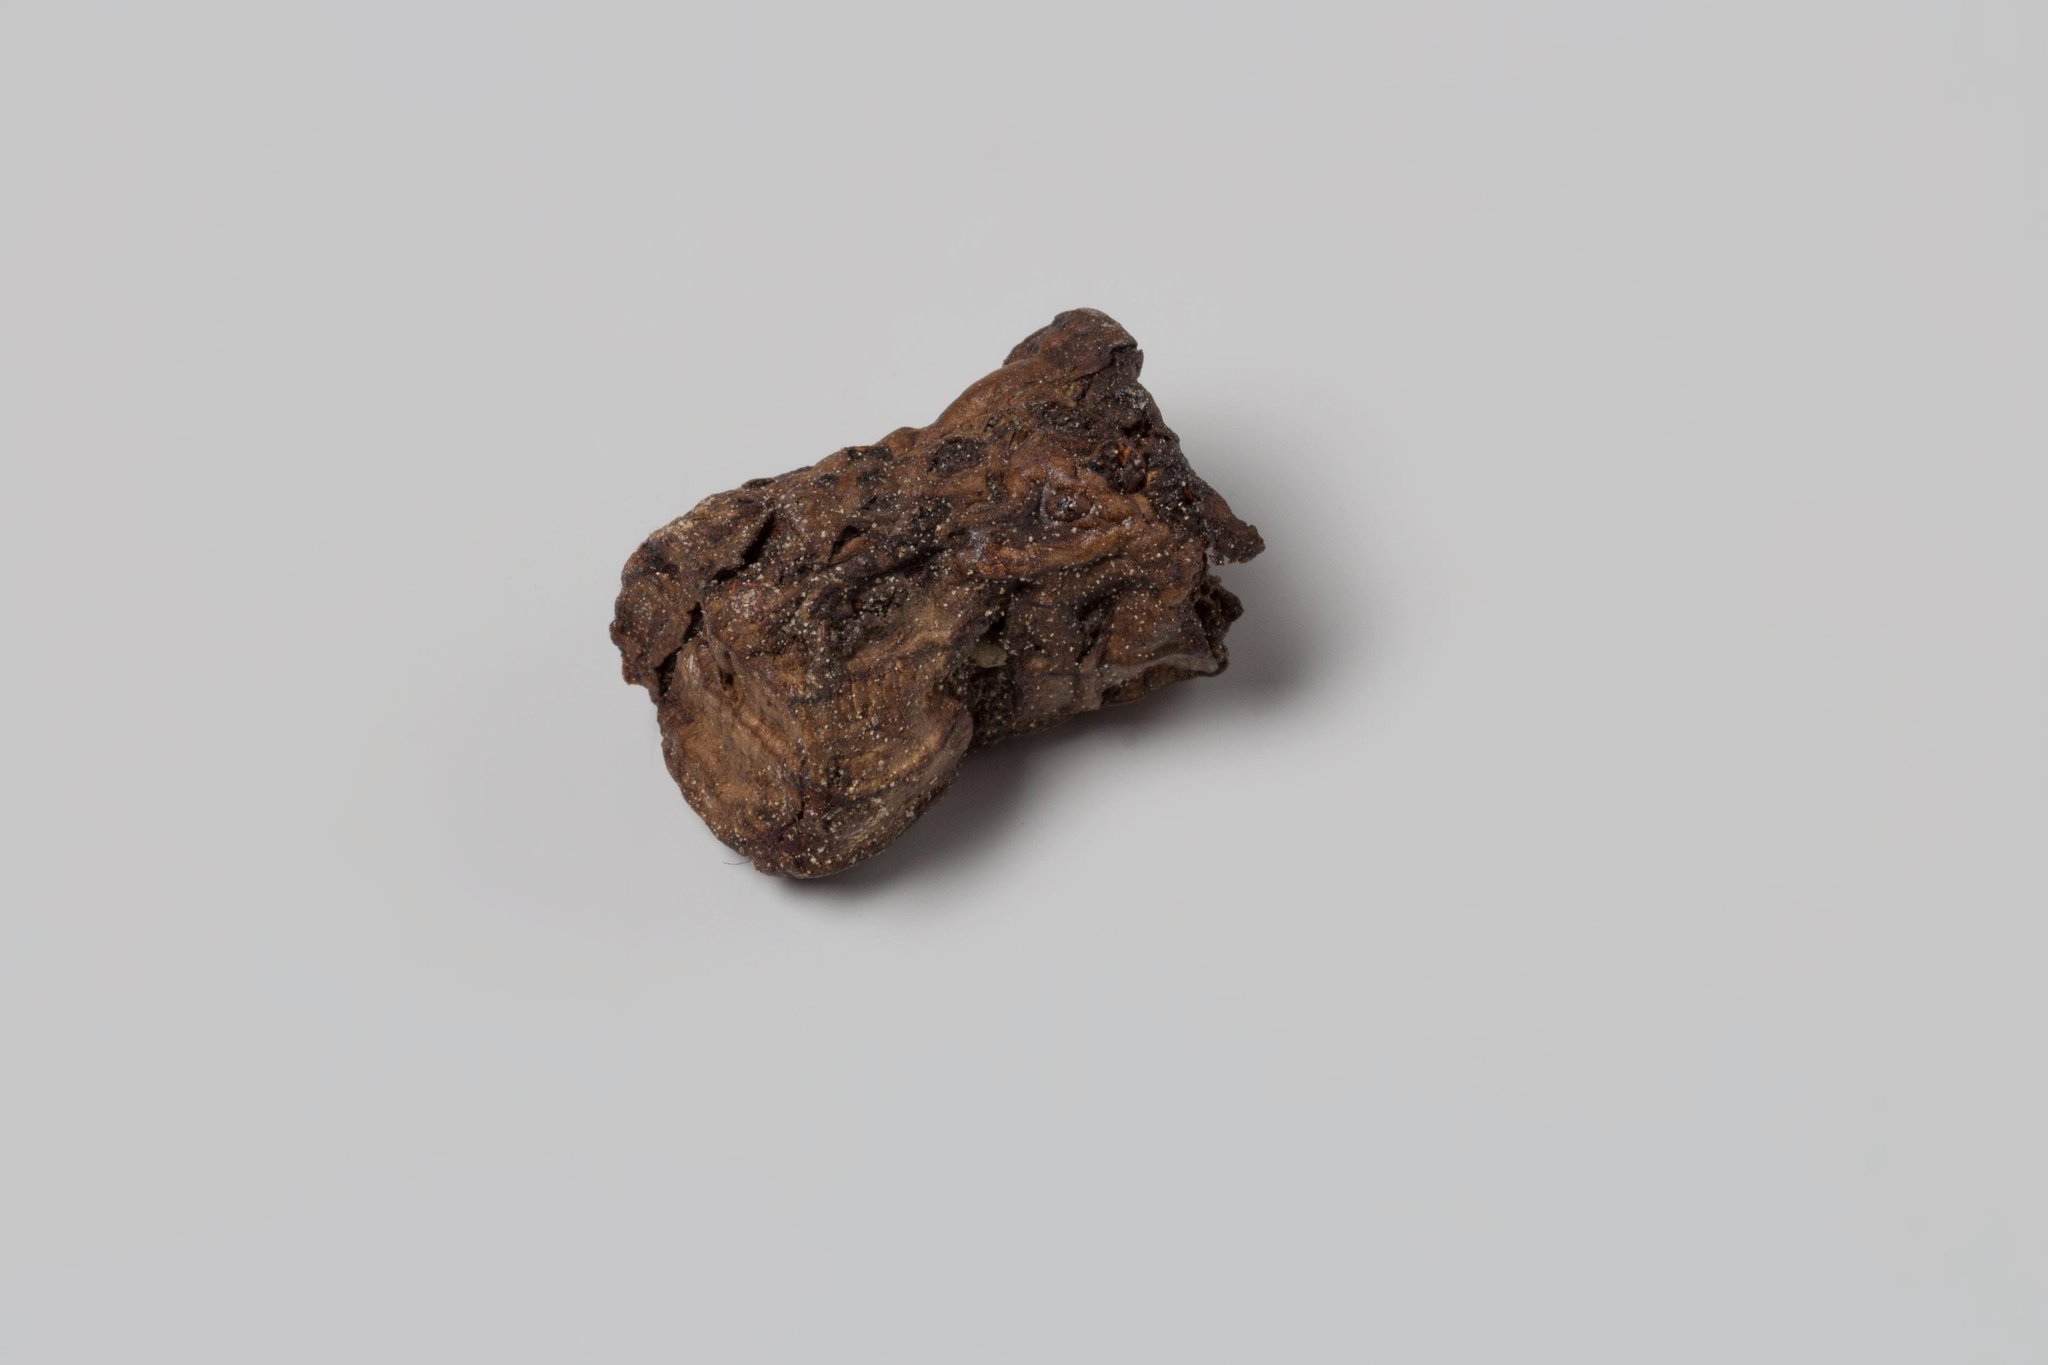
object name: cork stopper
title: Kurk uit het wrak van de Oost-Indiëvaarder 't Vliegend Hart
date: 1700-1735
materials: cork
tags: 't vliegend hart (schip), verenigde oostindische compagnie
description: De bruine kurk is afkomstig van een wijnfles (zie afmetingen). Cork.